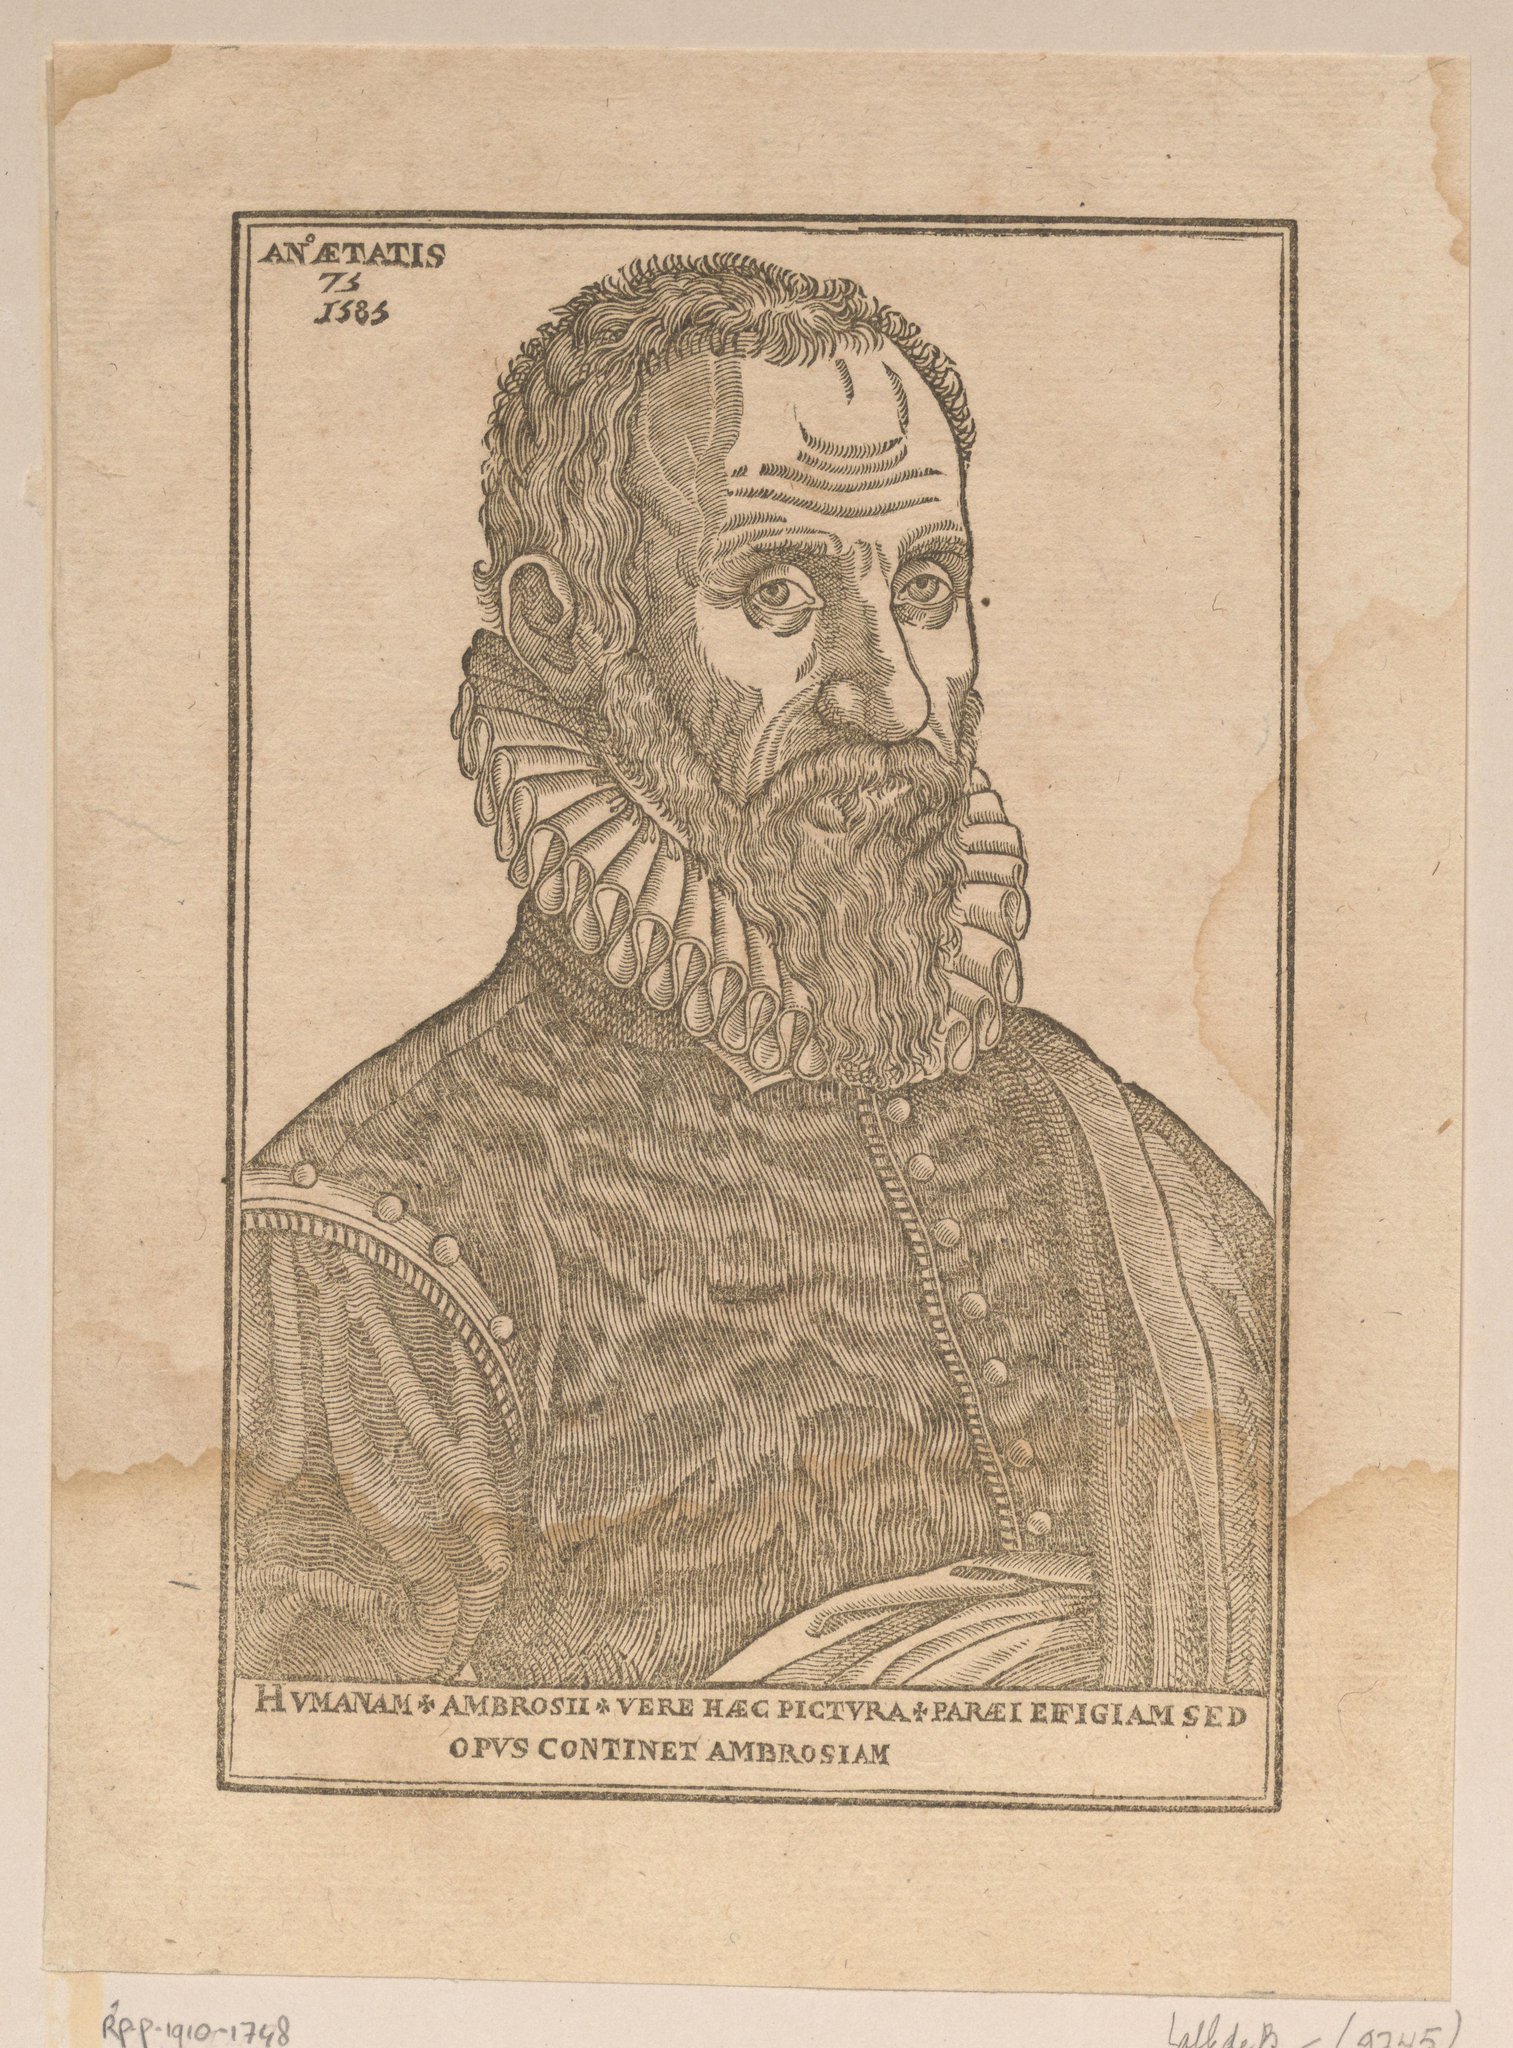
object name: print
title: Portret van Ambroise Paré op 75-jarige leeftijd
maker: Anonymous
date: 1633-1641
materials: paper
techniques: woodcut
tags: adult man, historical persons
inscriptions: collector's mark: Lugt 2228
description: Prent komt voor in: Paré, Ambroise. Les Oeuvres d'Ambroise Paré. Lyon: Rigaud et Obert, 1633. En in de uitgave van 1641. Mogelijk ook in eerdere en latere uitgaven van deze publicatie.